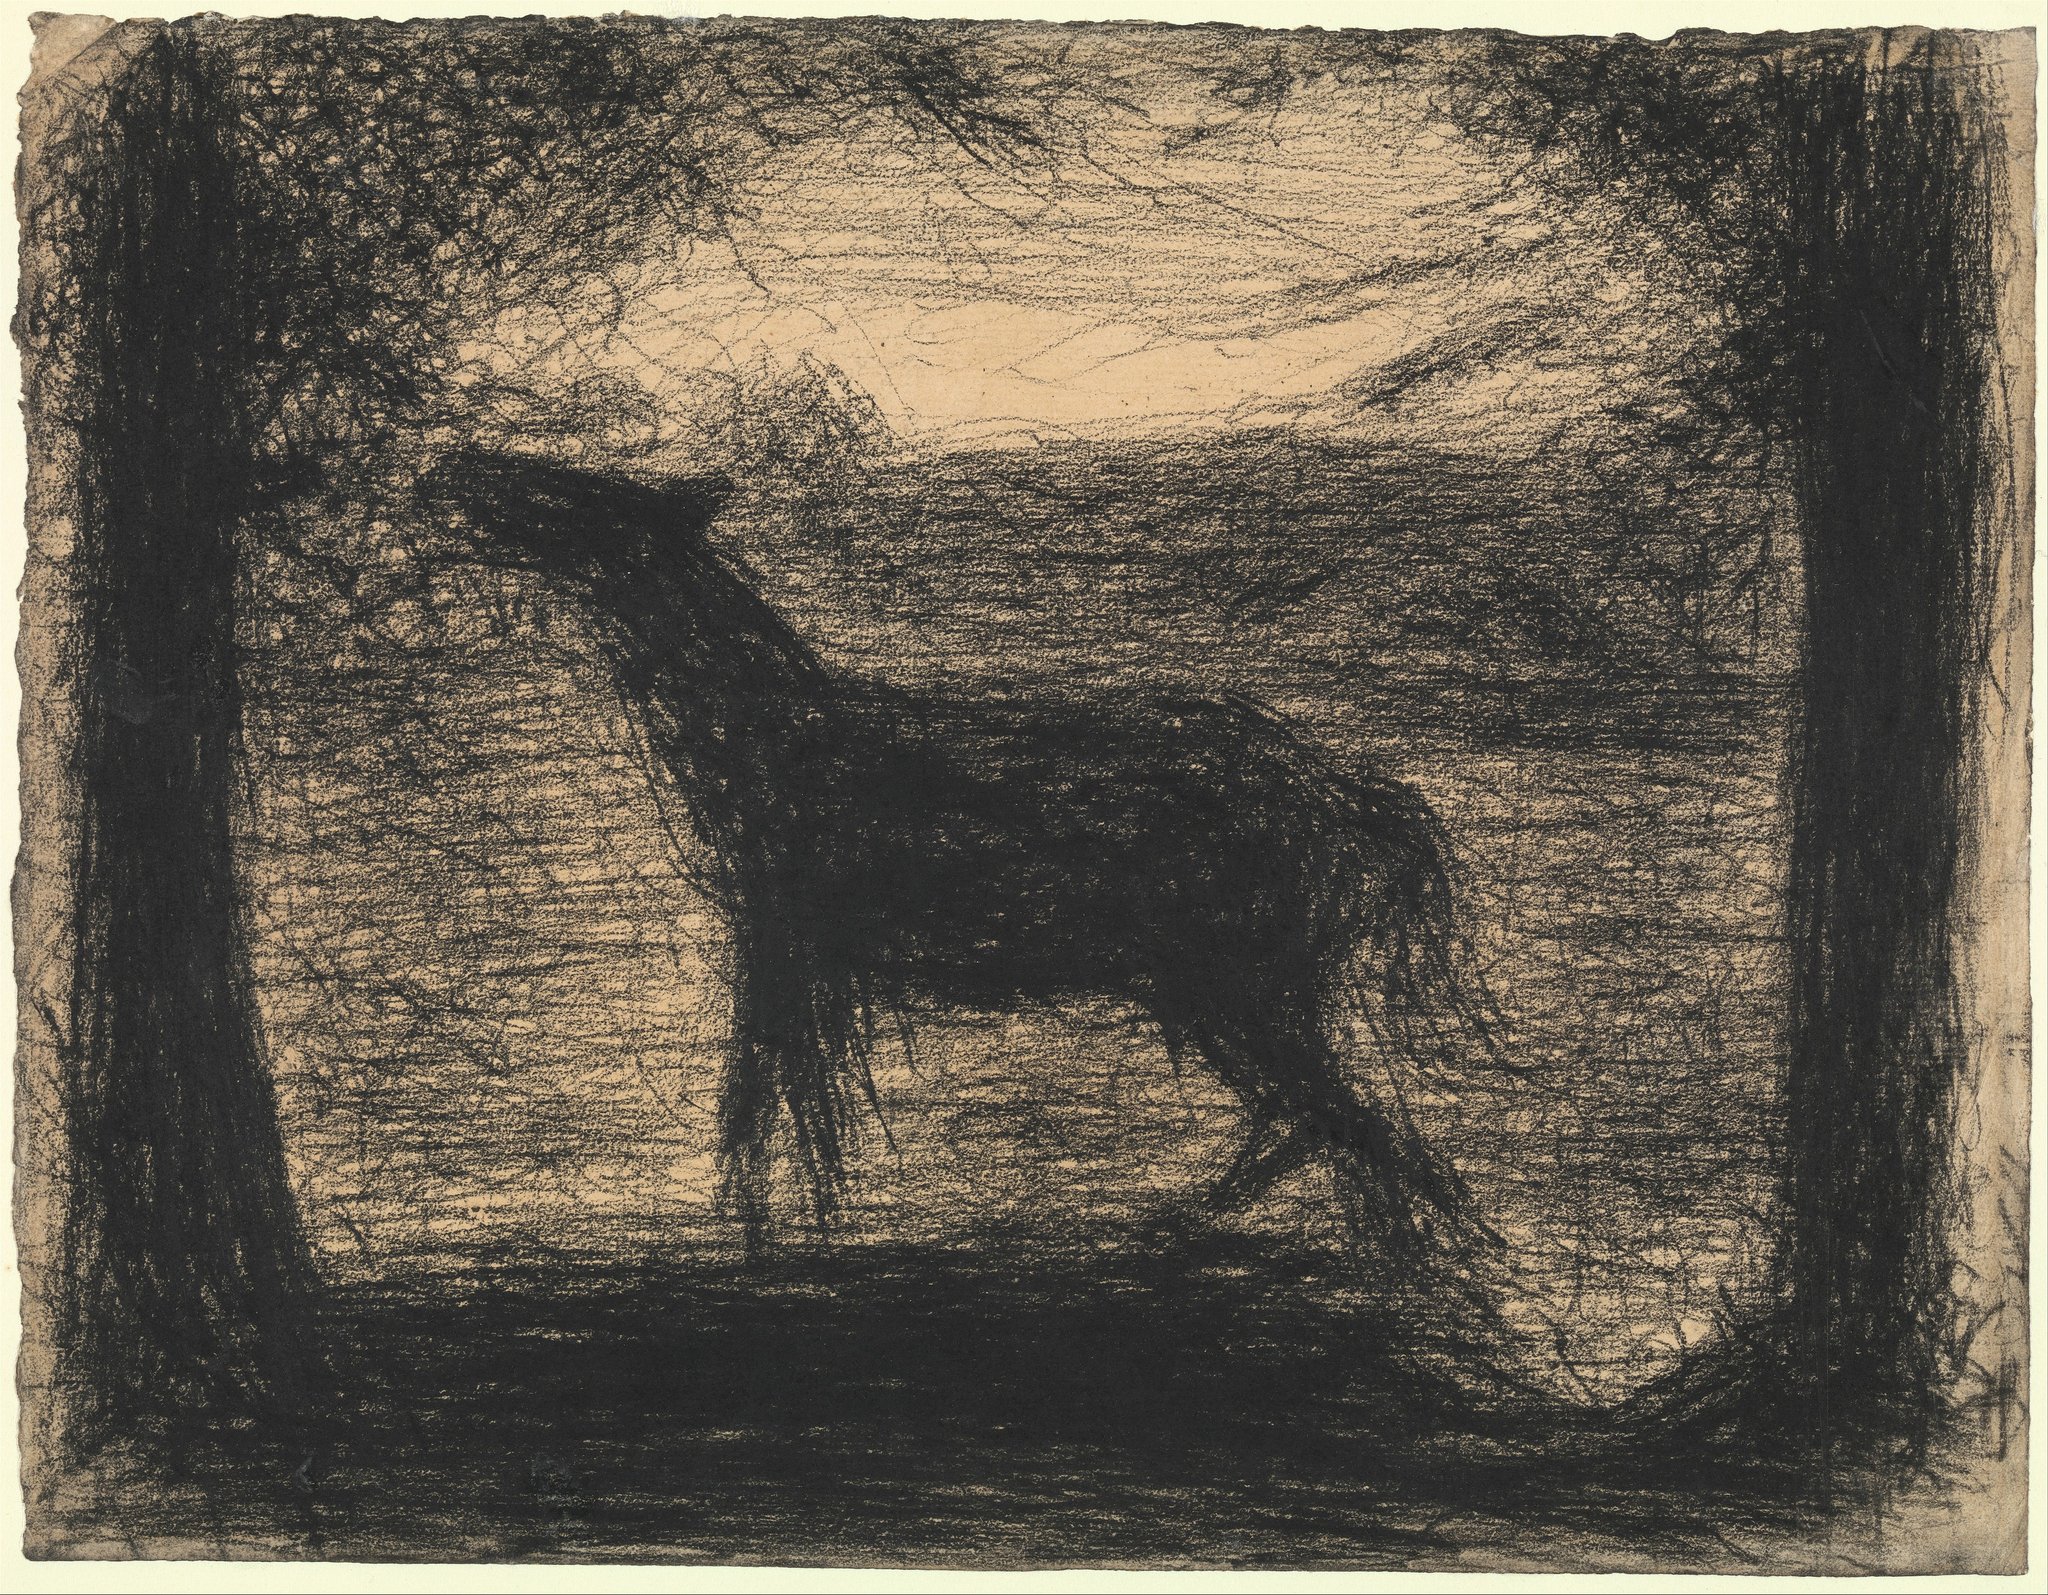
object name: drawing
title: Foal (Le Poulain) [also called "The Colt"]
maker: georges seurat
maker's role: artist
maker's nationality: french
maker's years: 1859-1891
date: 1882-1883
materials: crayon, paper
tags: horses